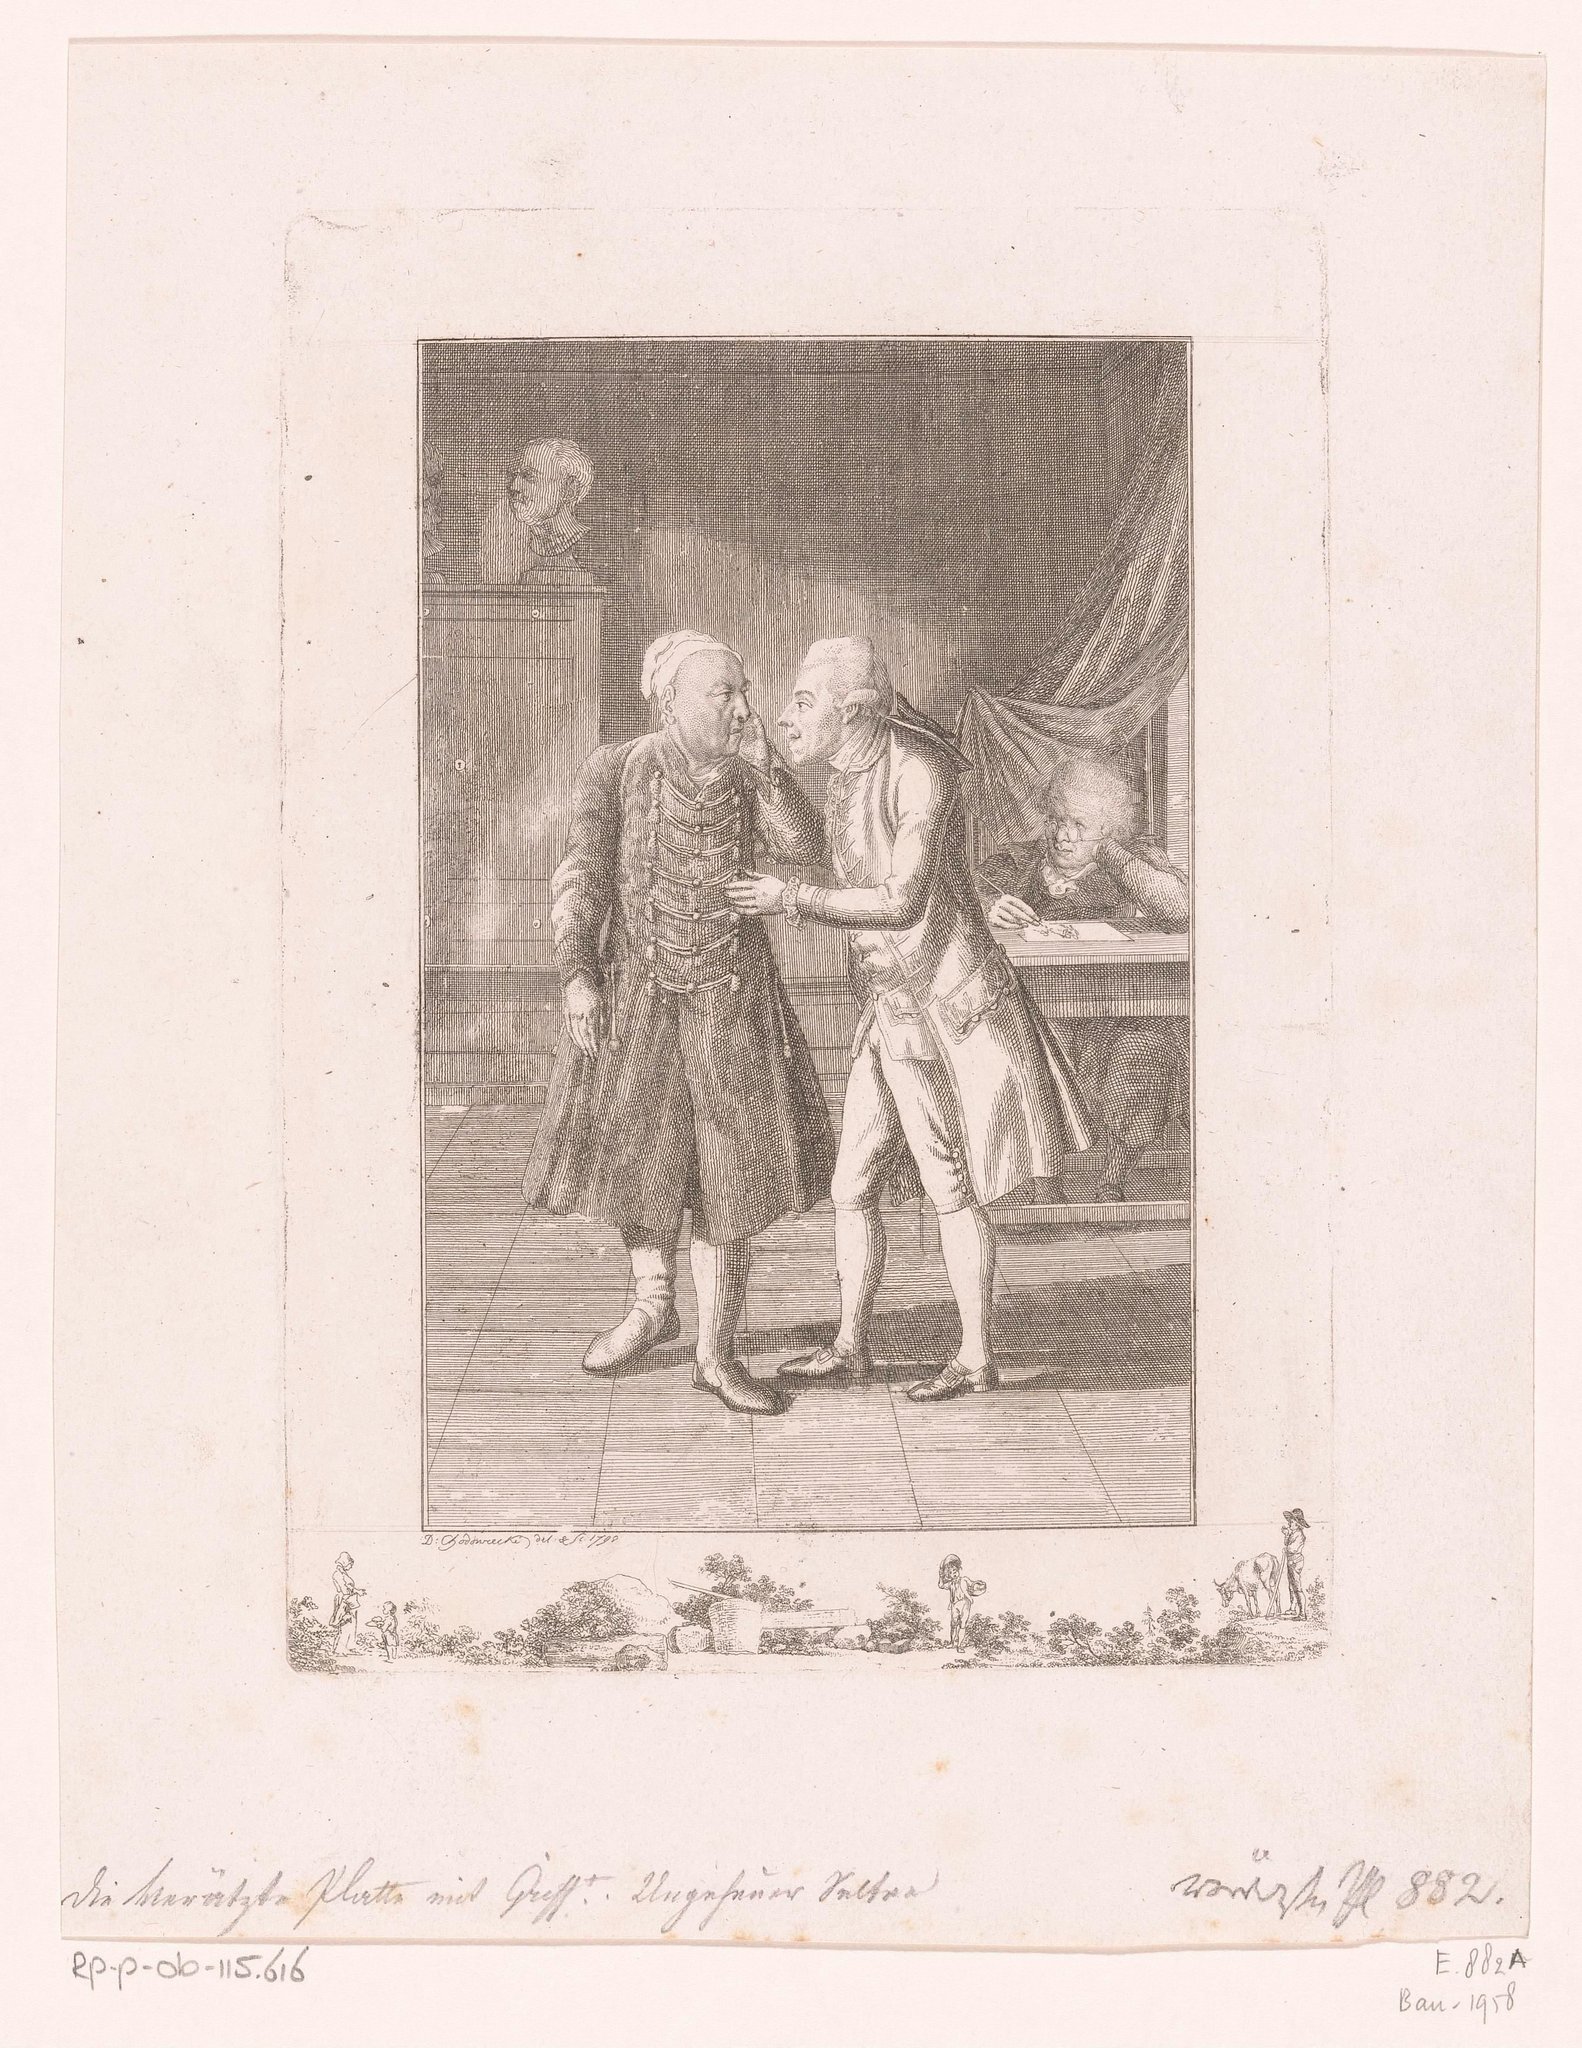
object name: print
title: Chodowiecki schetst Lippert en Zingg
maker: daniel nikolaus chodowiecki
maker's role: draughtsman, print maker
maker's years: 1726-1801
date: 1798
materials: paper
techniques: etching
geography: berlin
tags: adrian zingg, philip daniël lippert, berlin, print maker, draughtsman, daniel nikolaus chodowiecki, drawing, sketch, circle, club of artists, chest, bust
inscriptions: collector's mark: Lugt 2228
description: In de marge zijn op schetsmatige wijze figuren in een landschap geëtst.